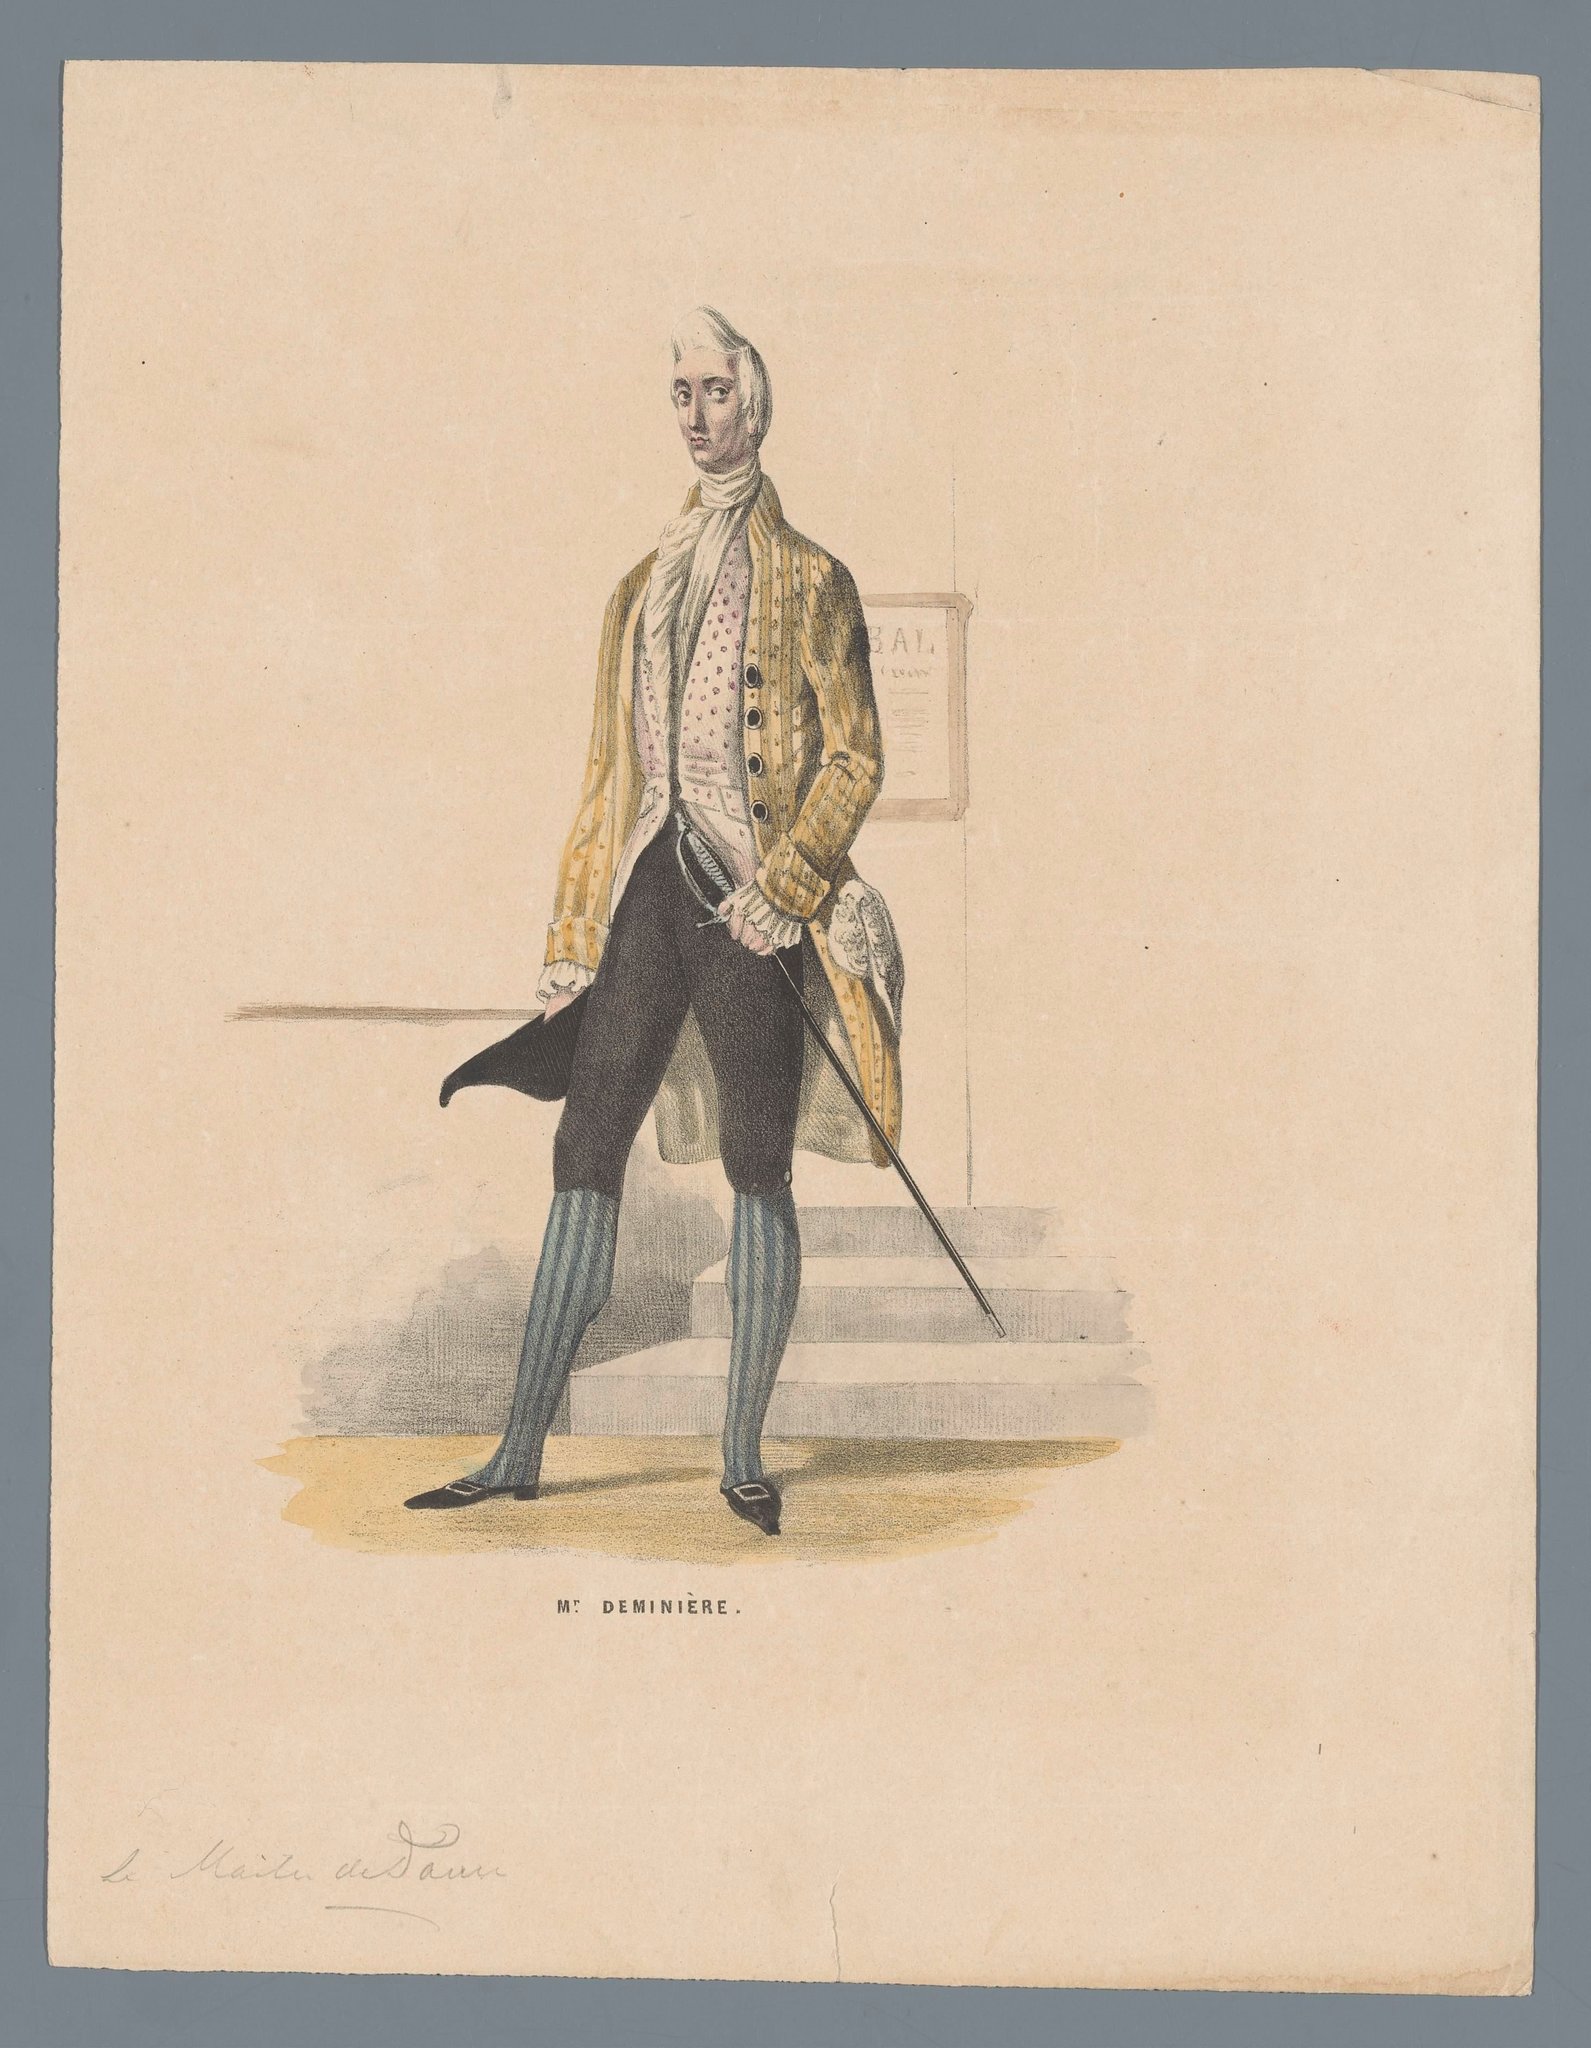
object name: costume print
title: Mr. Deminière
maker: elias spanier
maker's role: print maker, printer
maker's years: 1821-1863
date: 1840-1850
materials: paper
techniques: hand coloring, lithograph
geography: the hague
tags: the ballet, ballet performance, choreographer, historical costume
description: Mr. Deminière, de Franse balletmeester of hofdansmeester aan het koninklijke hof, in historisch kostuum. Voorstelling toegevoegd aan het plaatwerk over het gekostumeerd bal gehouden op het paleis van de prins van Oranje (de latere koning Willem III) in Den Haag op 26 februari 1845.